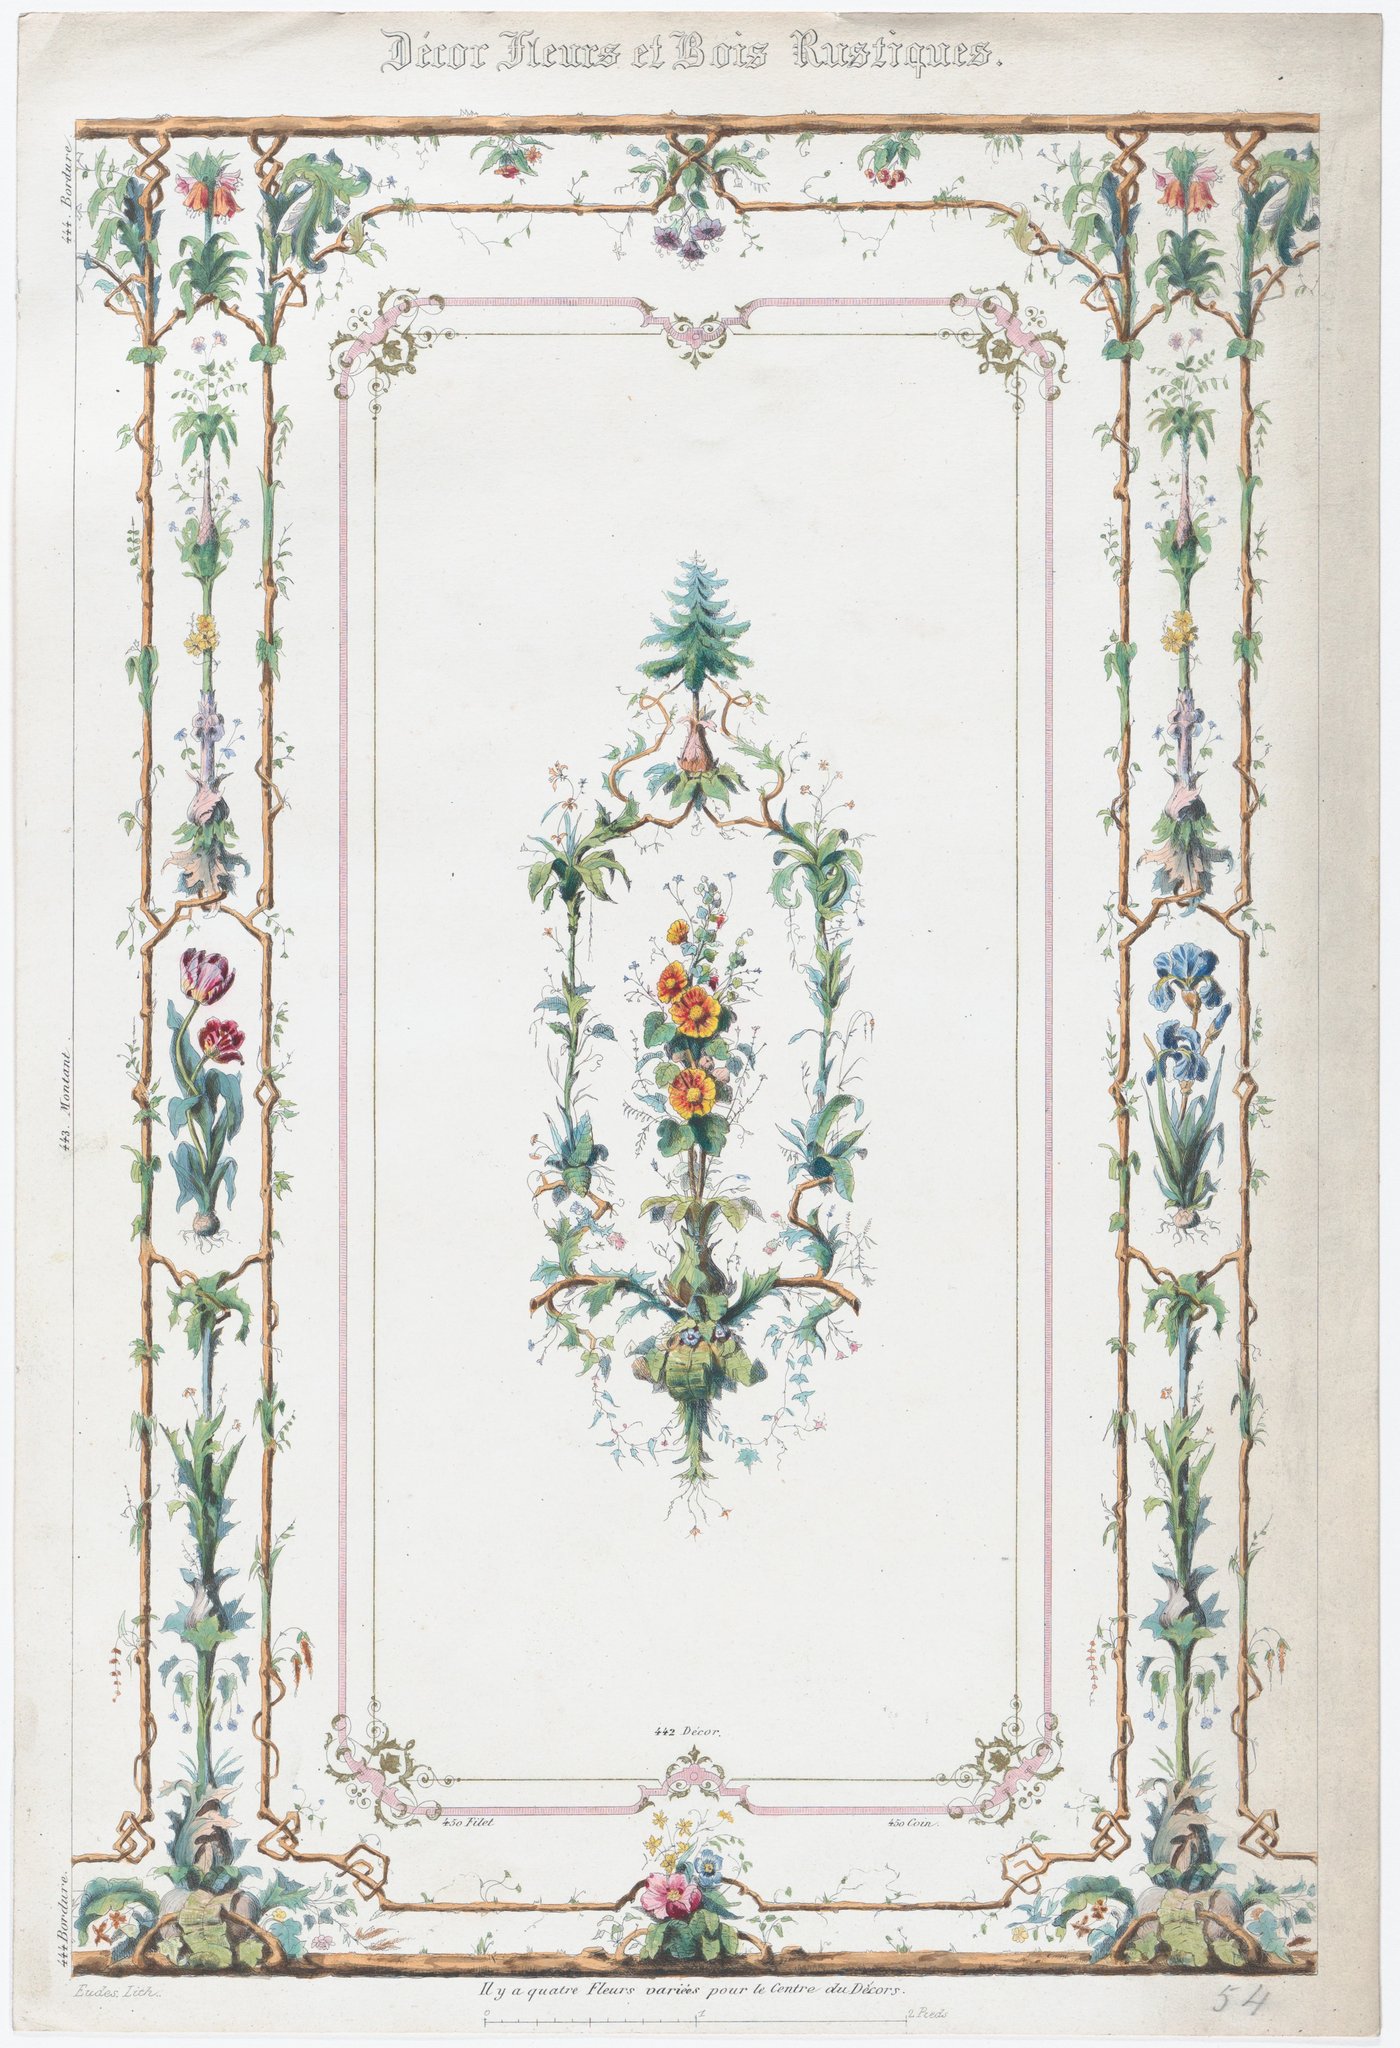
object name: print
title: Décor Fleurs et Bois Rustiques.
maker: anonymous, french, 19th century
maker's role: artist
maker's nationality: french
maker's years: 1800-1900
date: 1801-1900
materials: watercolor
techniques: lithograph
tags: flowers